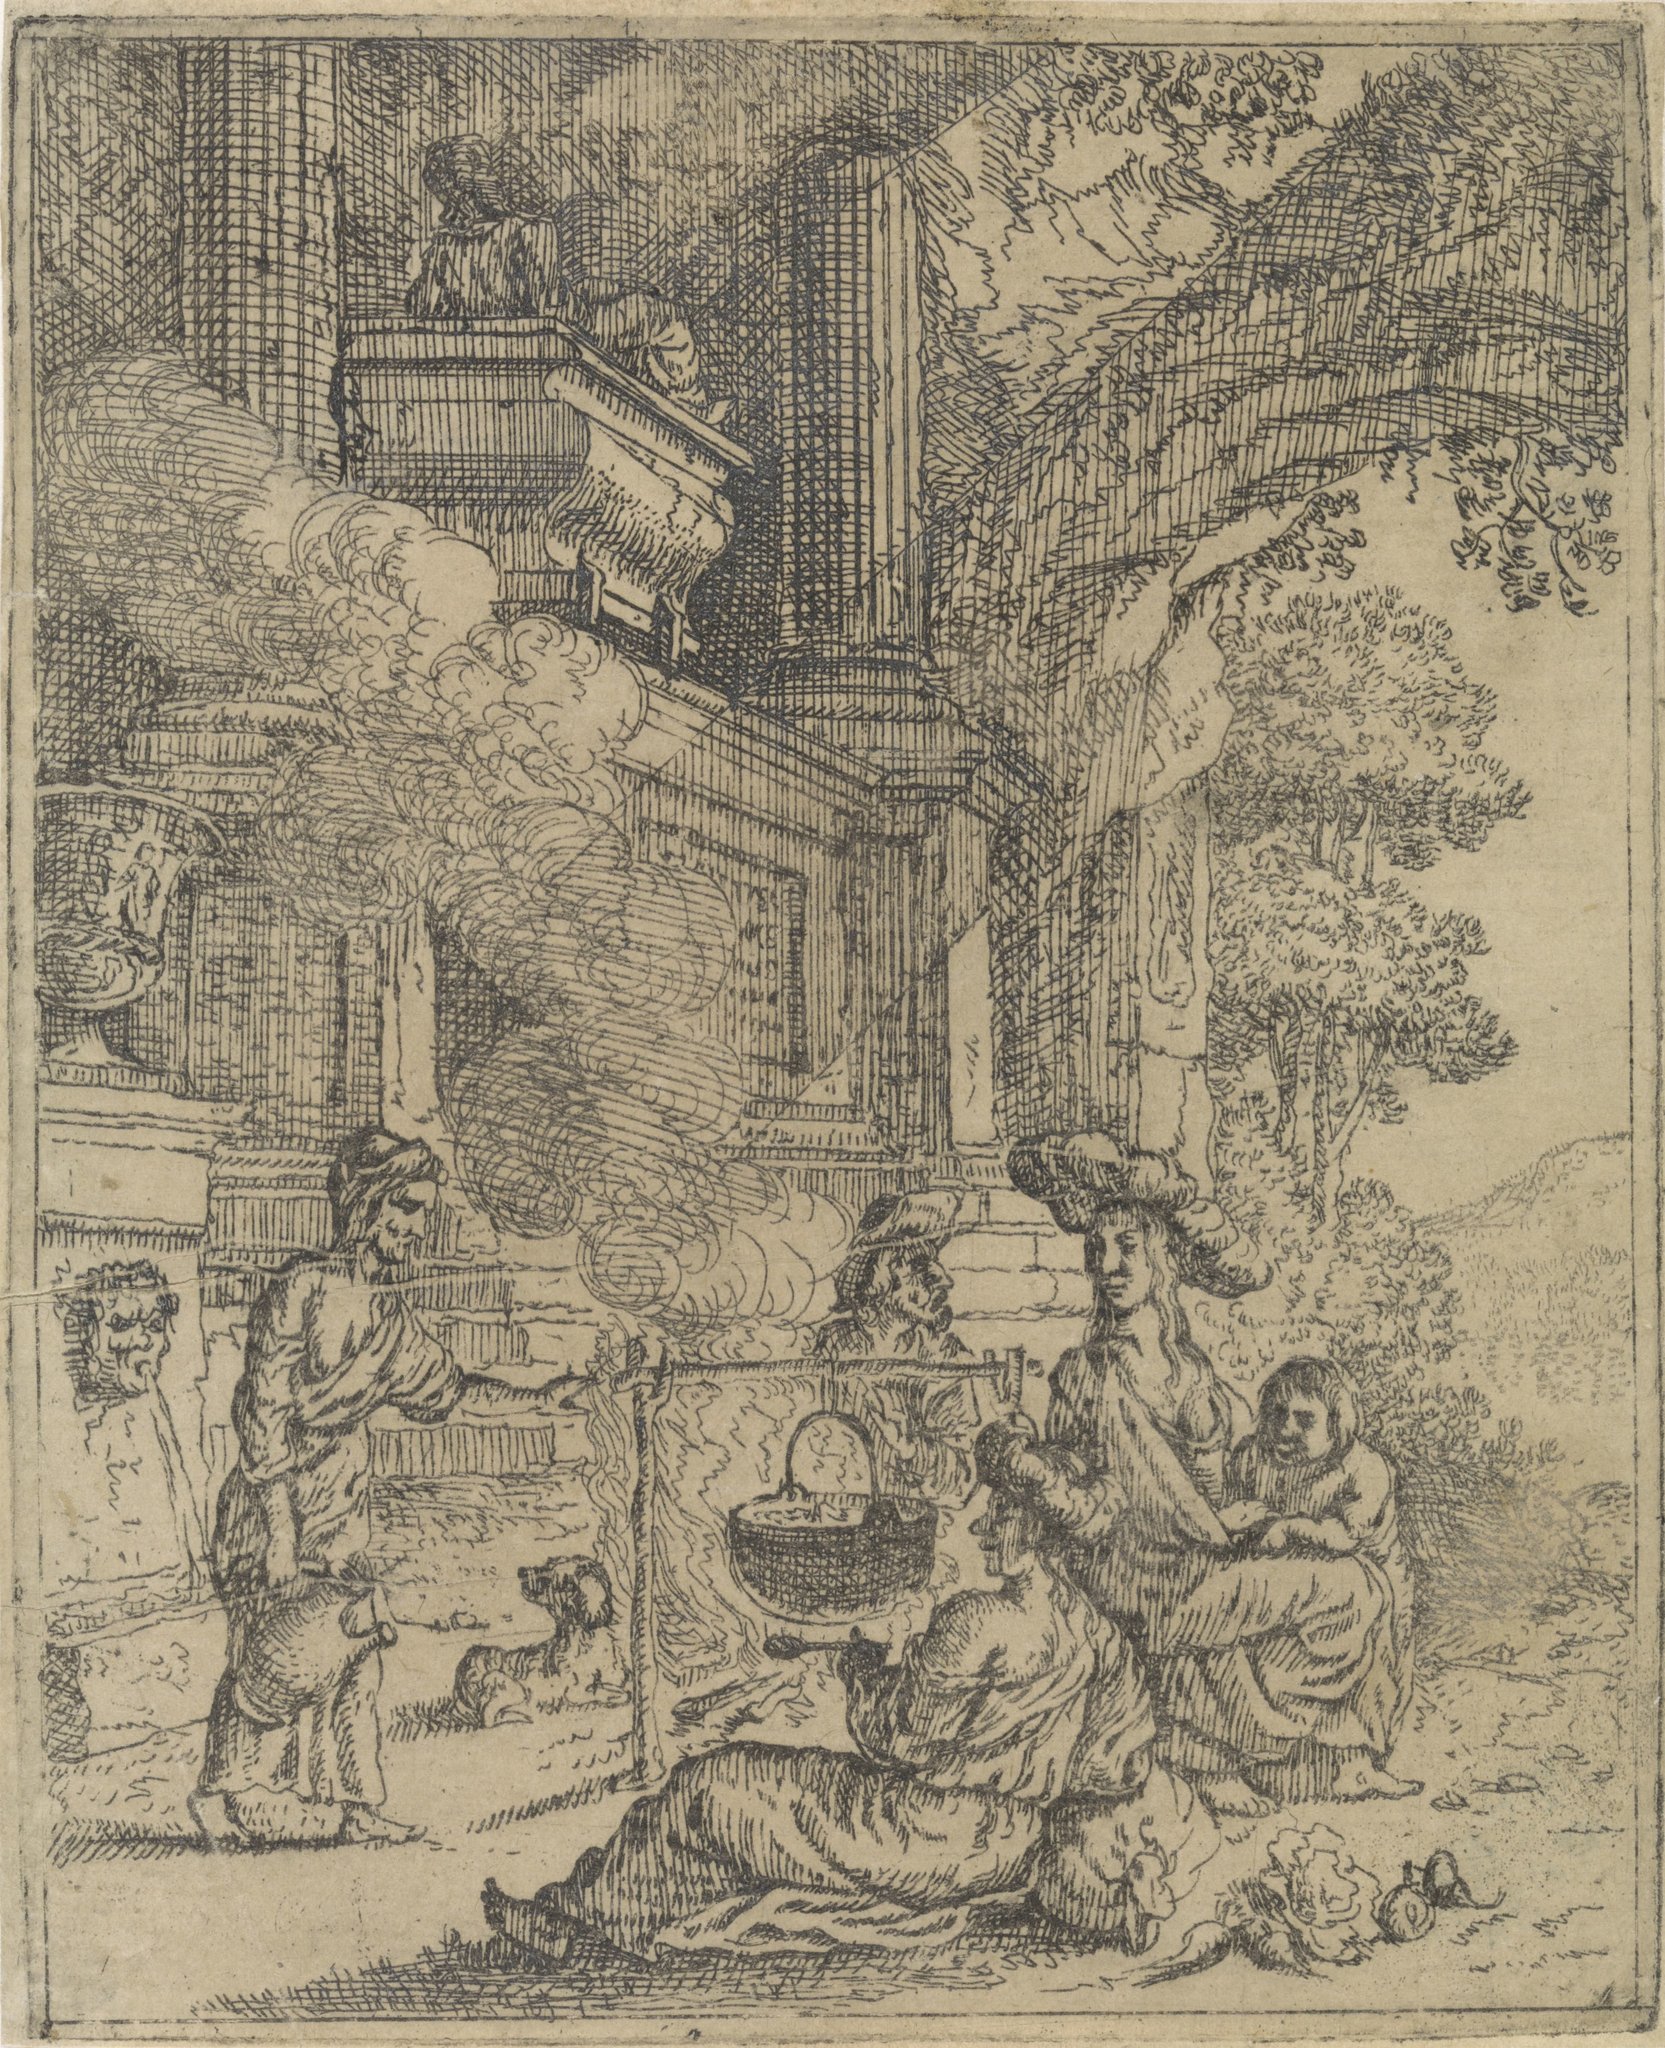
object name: print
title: Klassieke ruïnes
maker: frans geffels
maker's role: draughtsman, painter, print maker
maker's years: 1625-1694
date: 1659-1671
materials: paper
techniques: etching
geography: mantua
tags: landscape with ruins, wandering communities: romani or roma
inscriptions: collector's mark: Lugt 2166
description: Een antieke ruïne. Op de voorgrond kookt een zigeunerfamilie wat soep. De prent is deel van een zevendelige serie met antieke ruïnes.